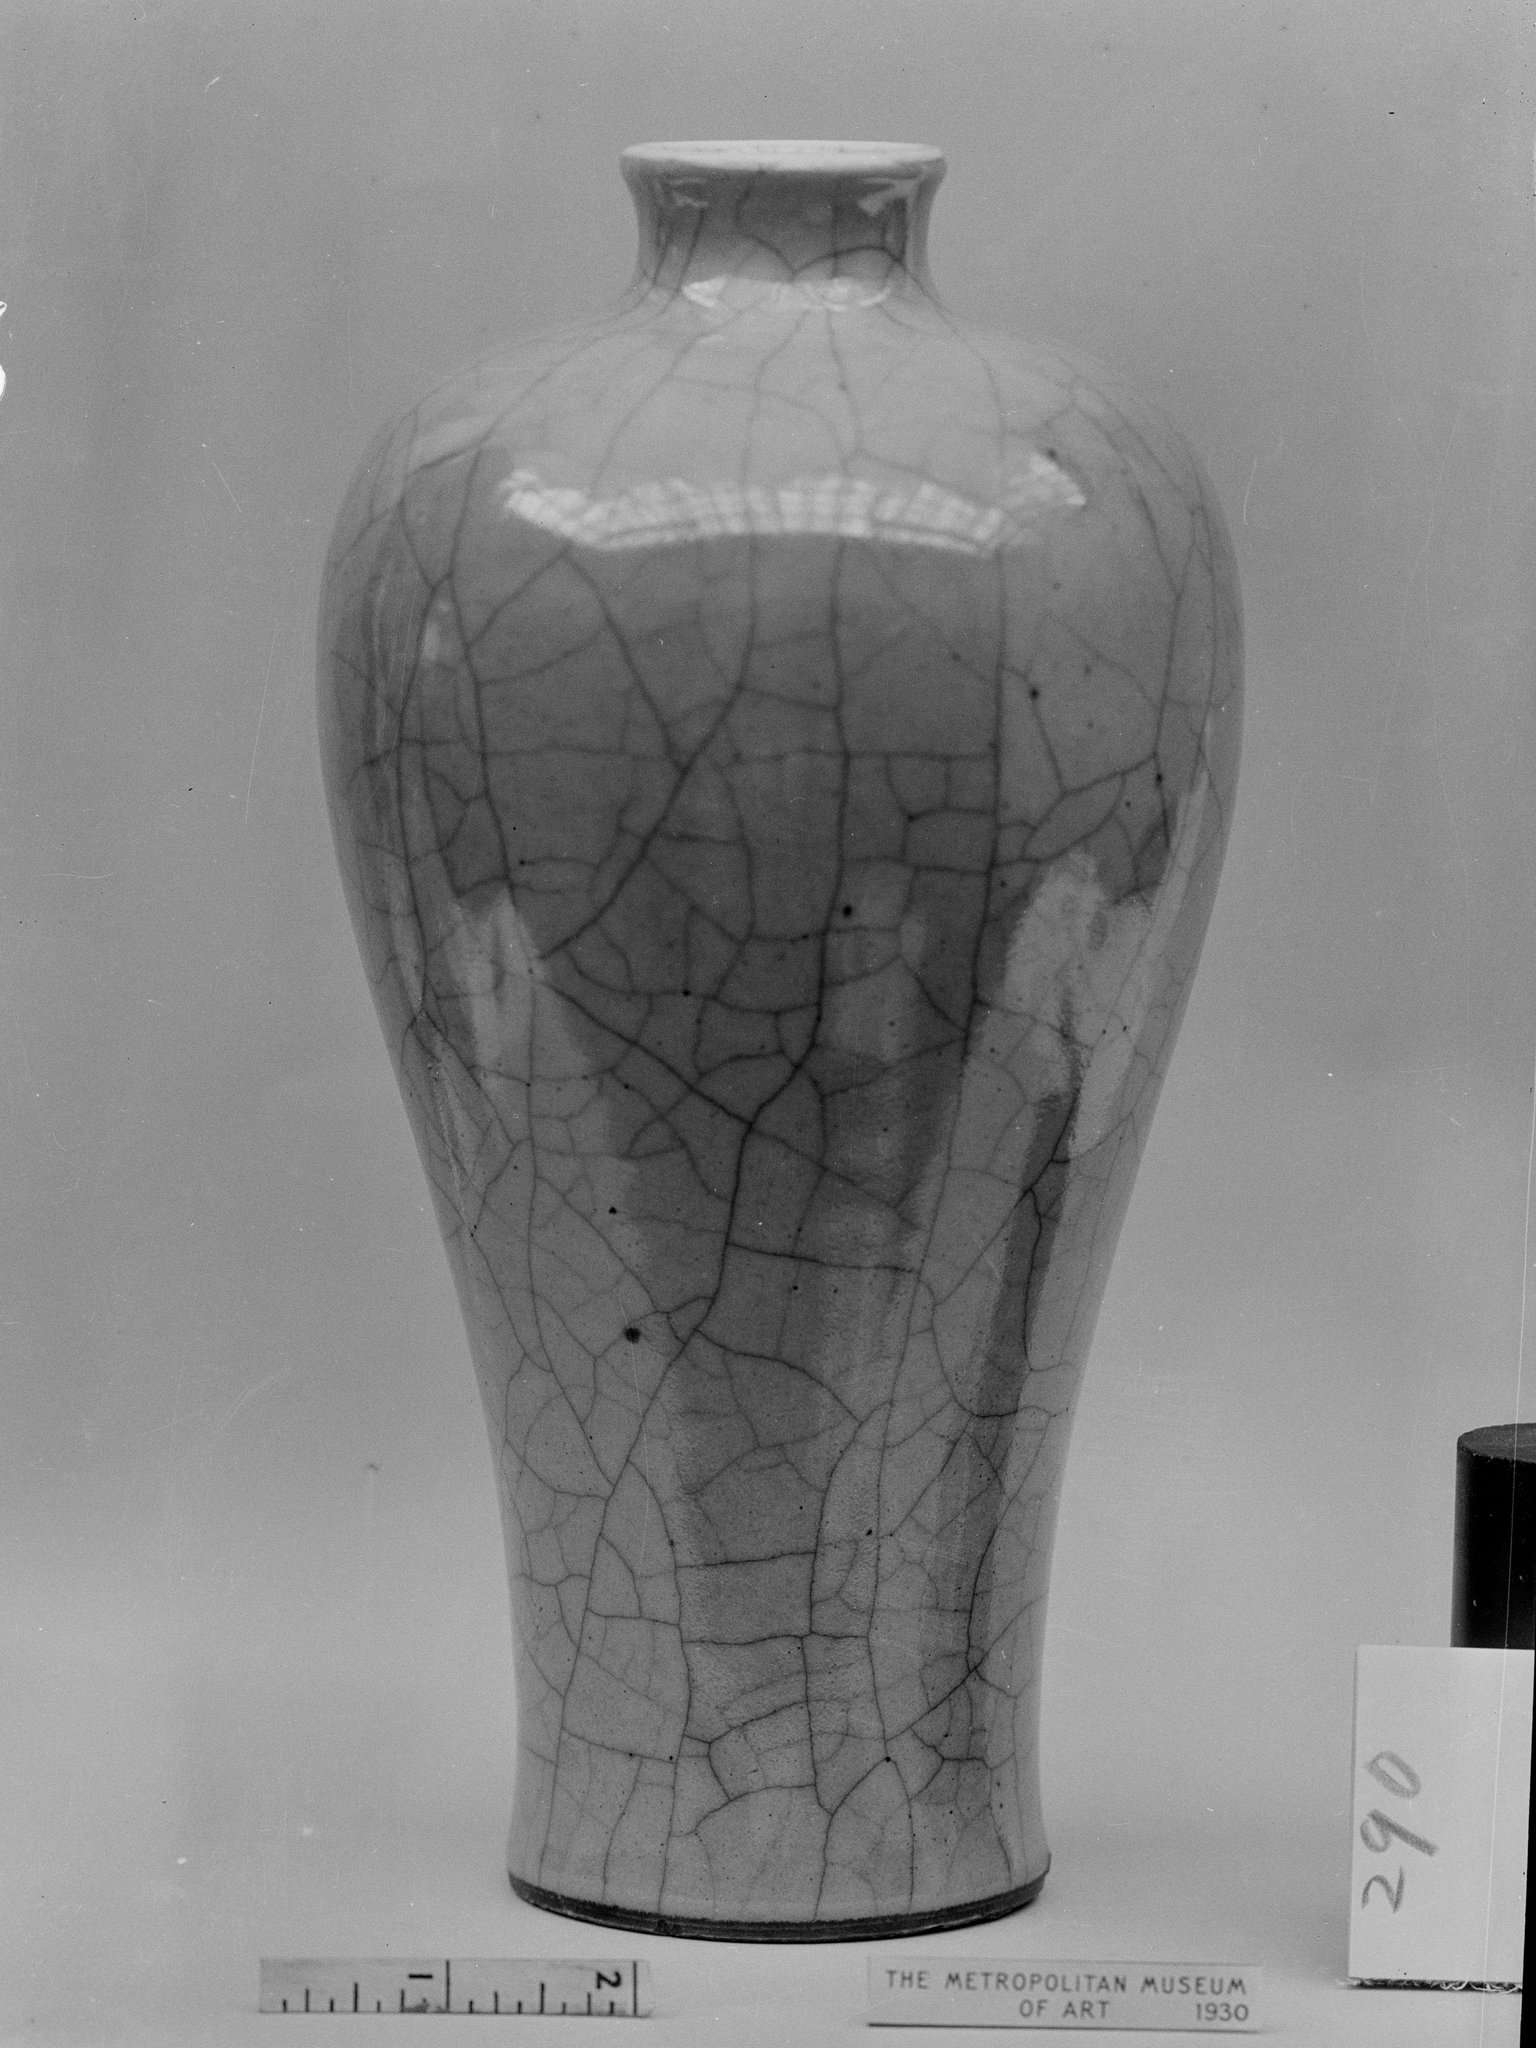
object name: vase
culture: chinese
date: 1736-1795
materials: porcelain